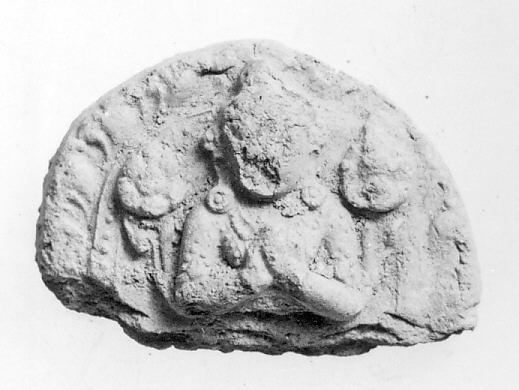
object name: plaque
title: Votive Plaque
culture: central asian or tibetan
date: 1401-1700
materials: clay